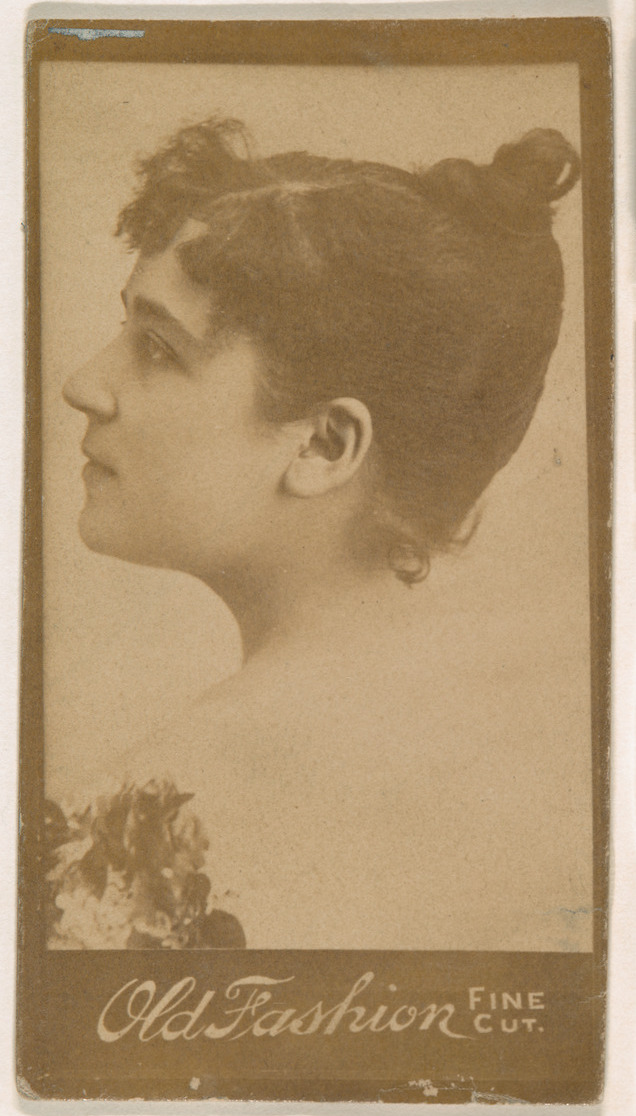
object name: photograph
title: Portrait of actress in profile, from the Actresses series (N664) promoting Old Fashion Fine Cut Tobacco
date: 1888-1890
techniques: albumen silver print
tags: portraits,profiles,women,actresses